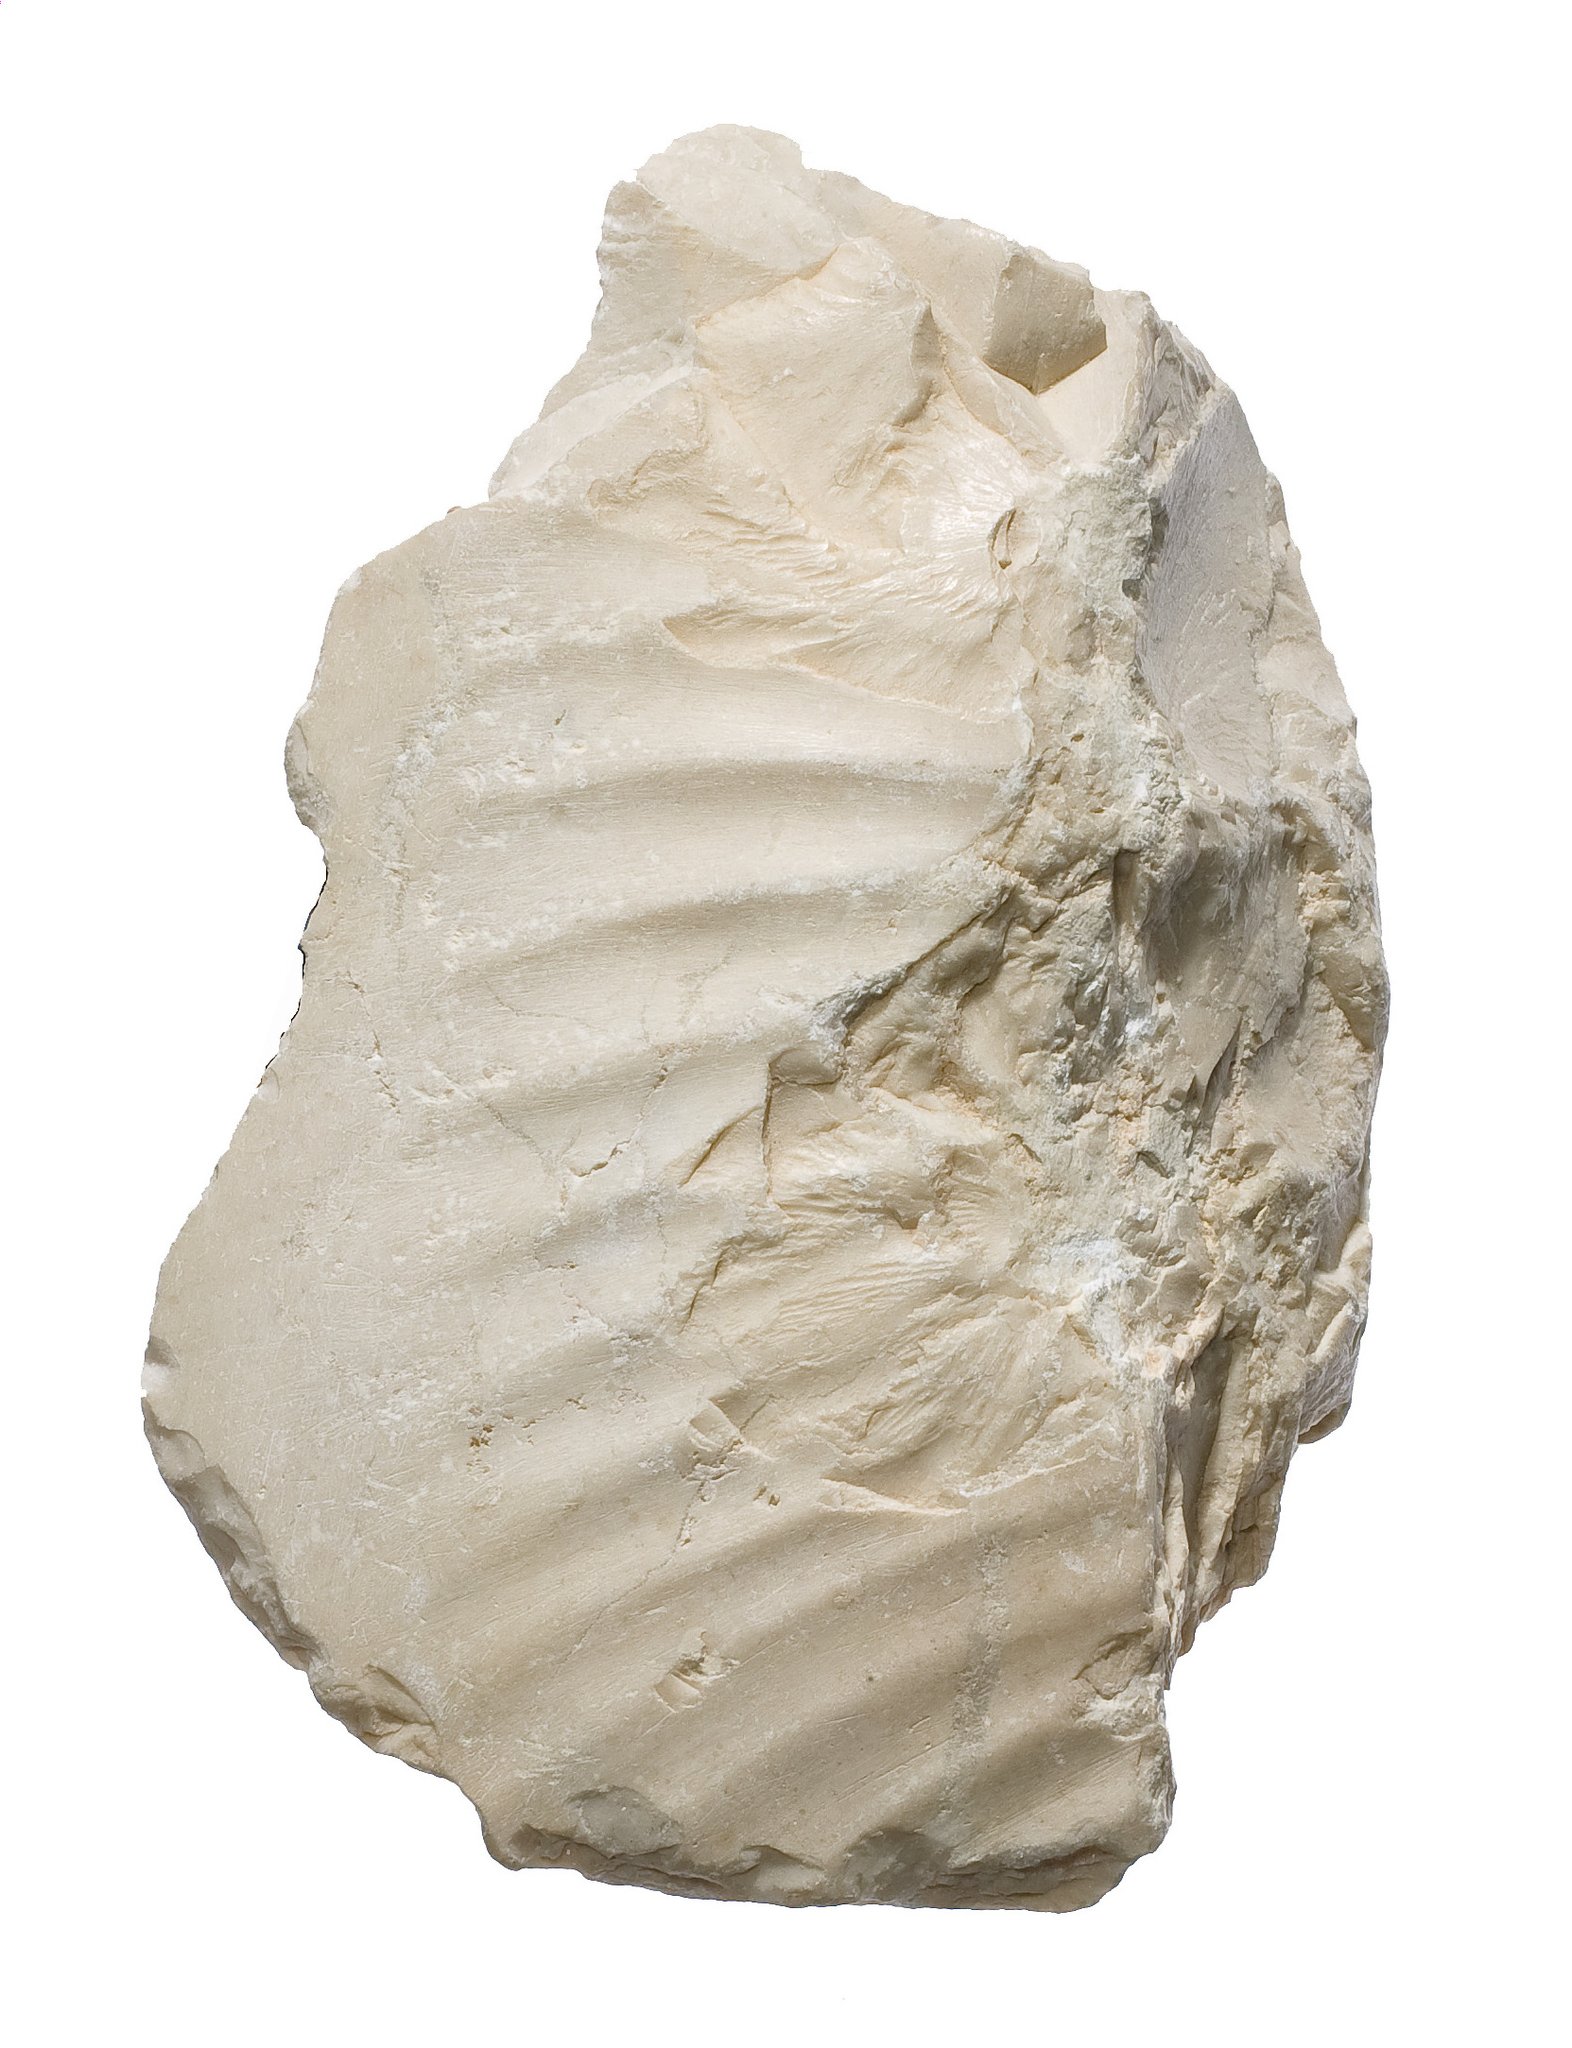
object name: garment fragment, male, gather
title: Kilt gathers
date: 1353-1336 BCE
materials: limestone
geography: egypt